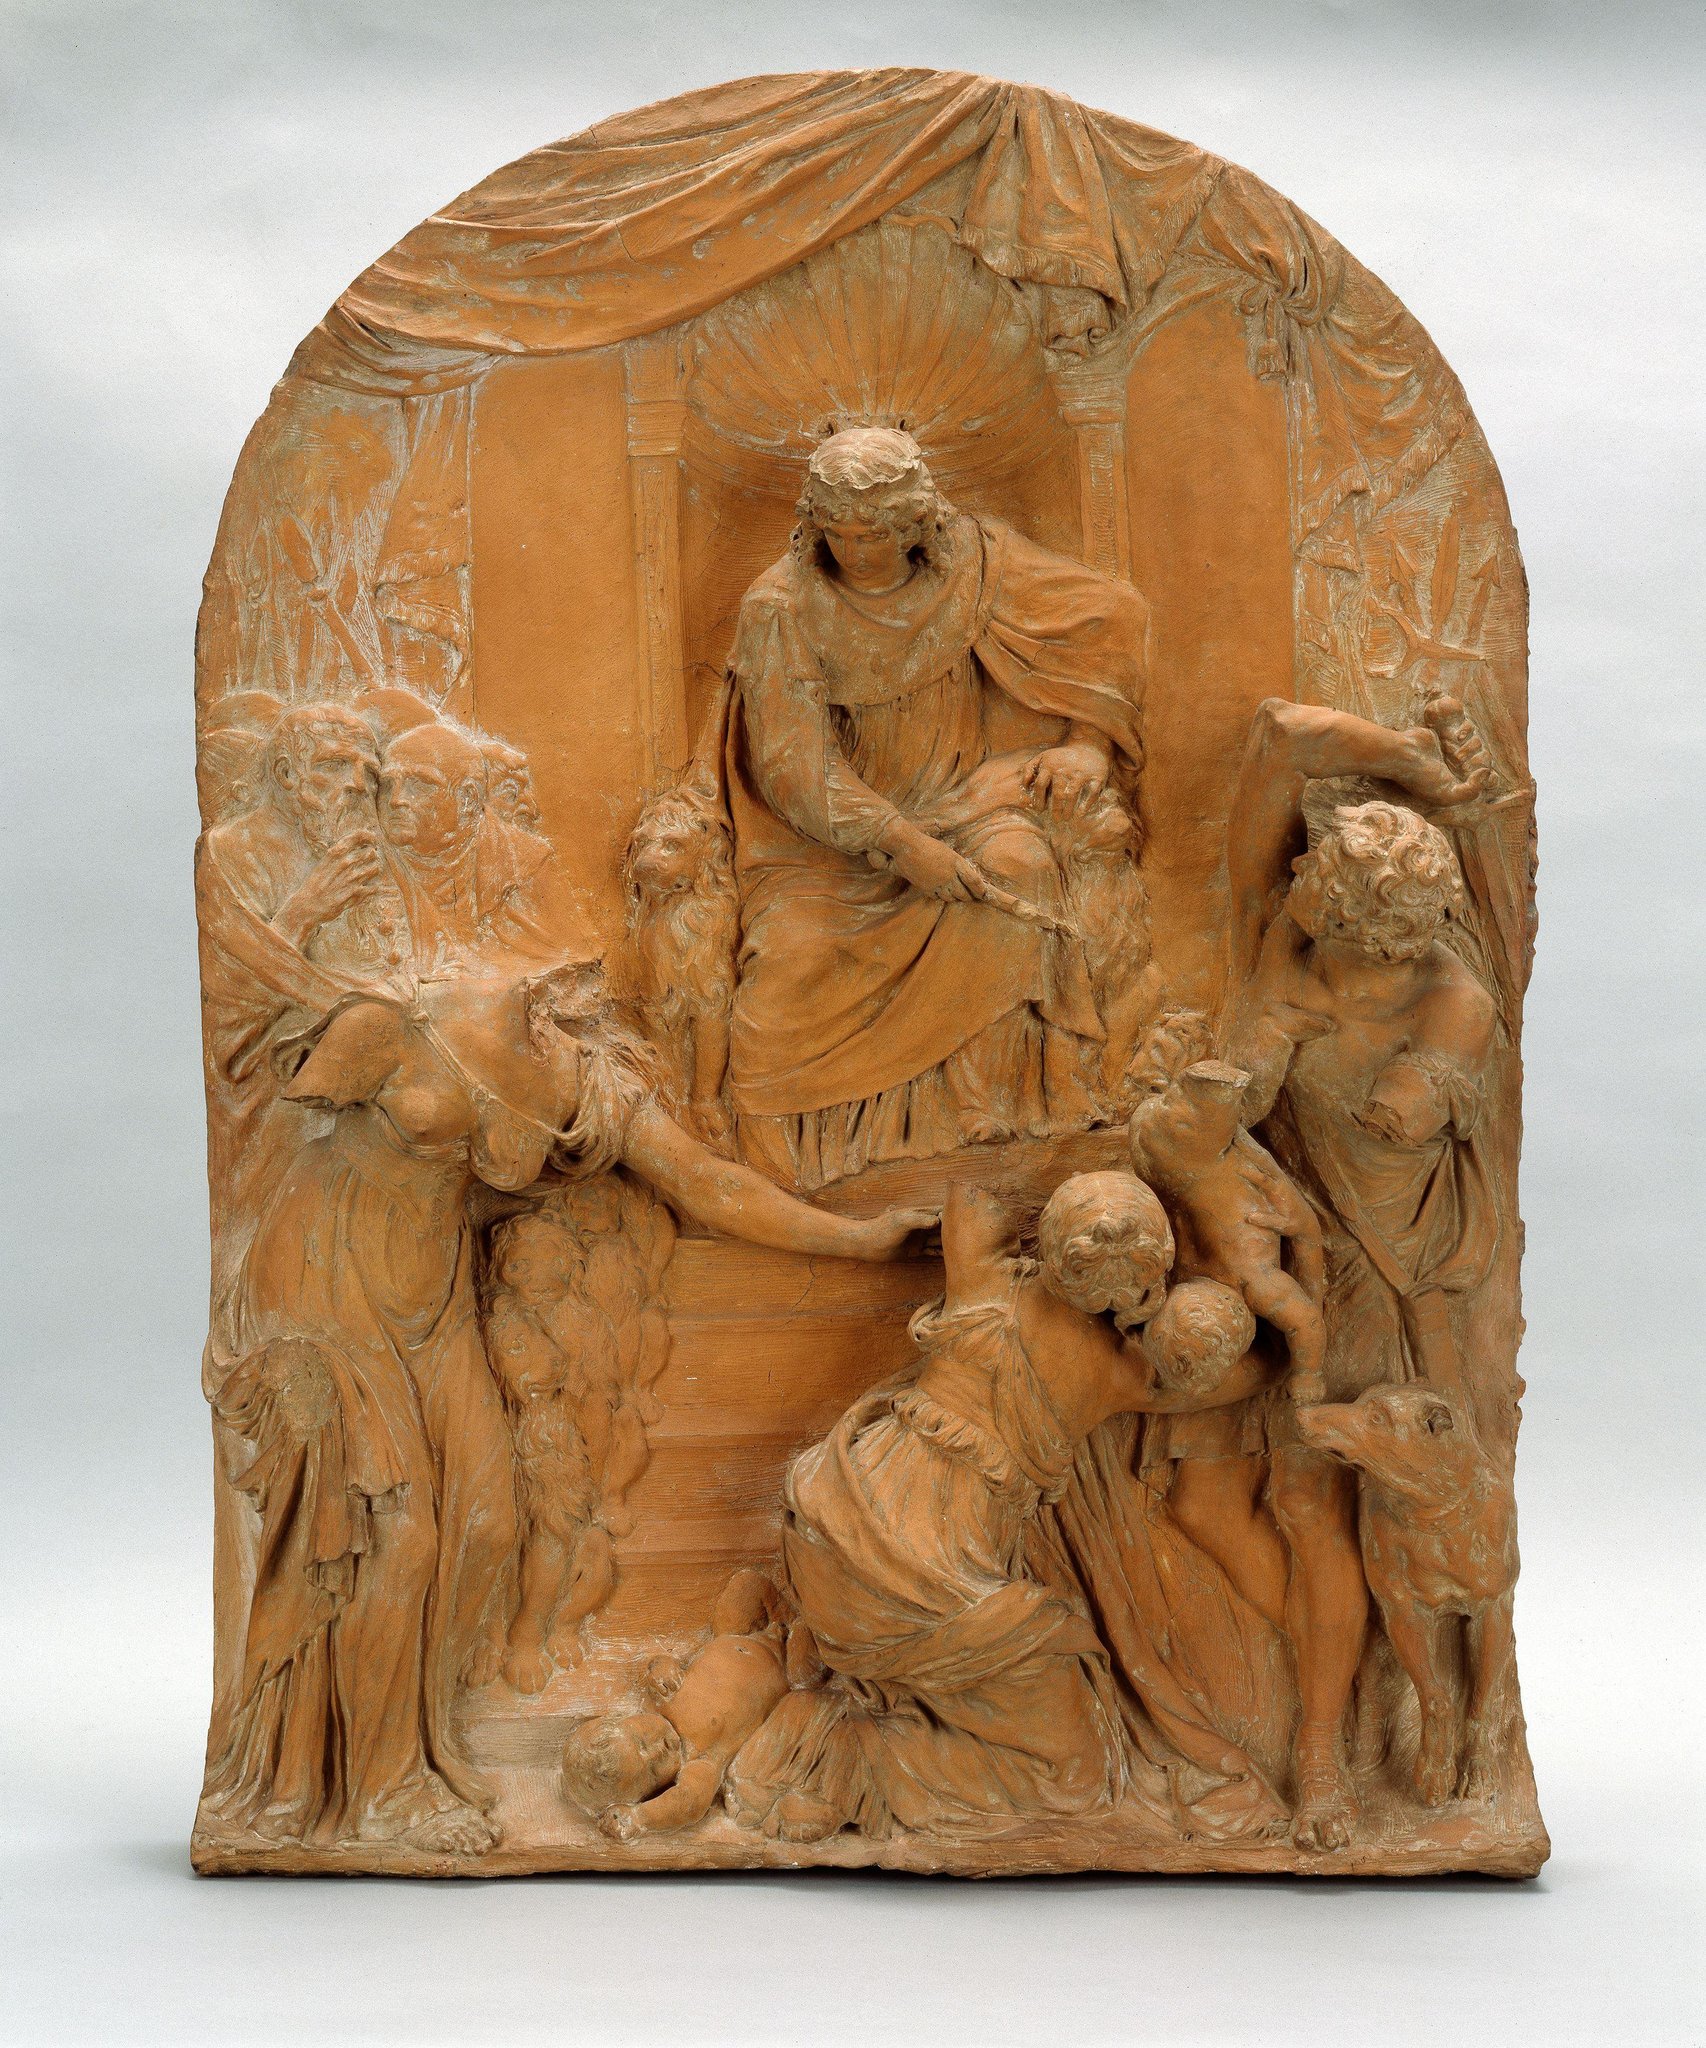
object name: model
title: The Judgement of Solomon, Model for a Relief in the Vierschaar of the Amsterdam Town Hall (now Royal Palace) at Dam Square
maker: artus quellinus (i)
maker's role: draughtsman, print maker, sculptor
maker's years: 1609-1668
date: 1650-1652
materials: terracotta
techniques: modeling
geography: amsterdam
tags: the judgement of solomon (1 kings 3:16-28)